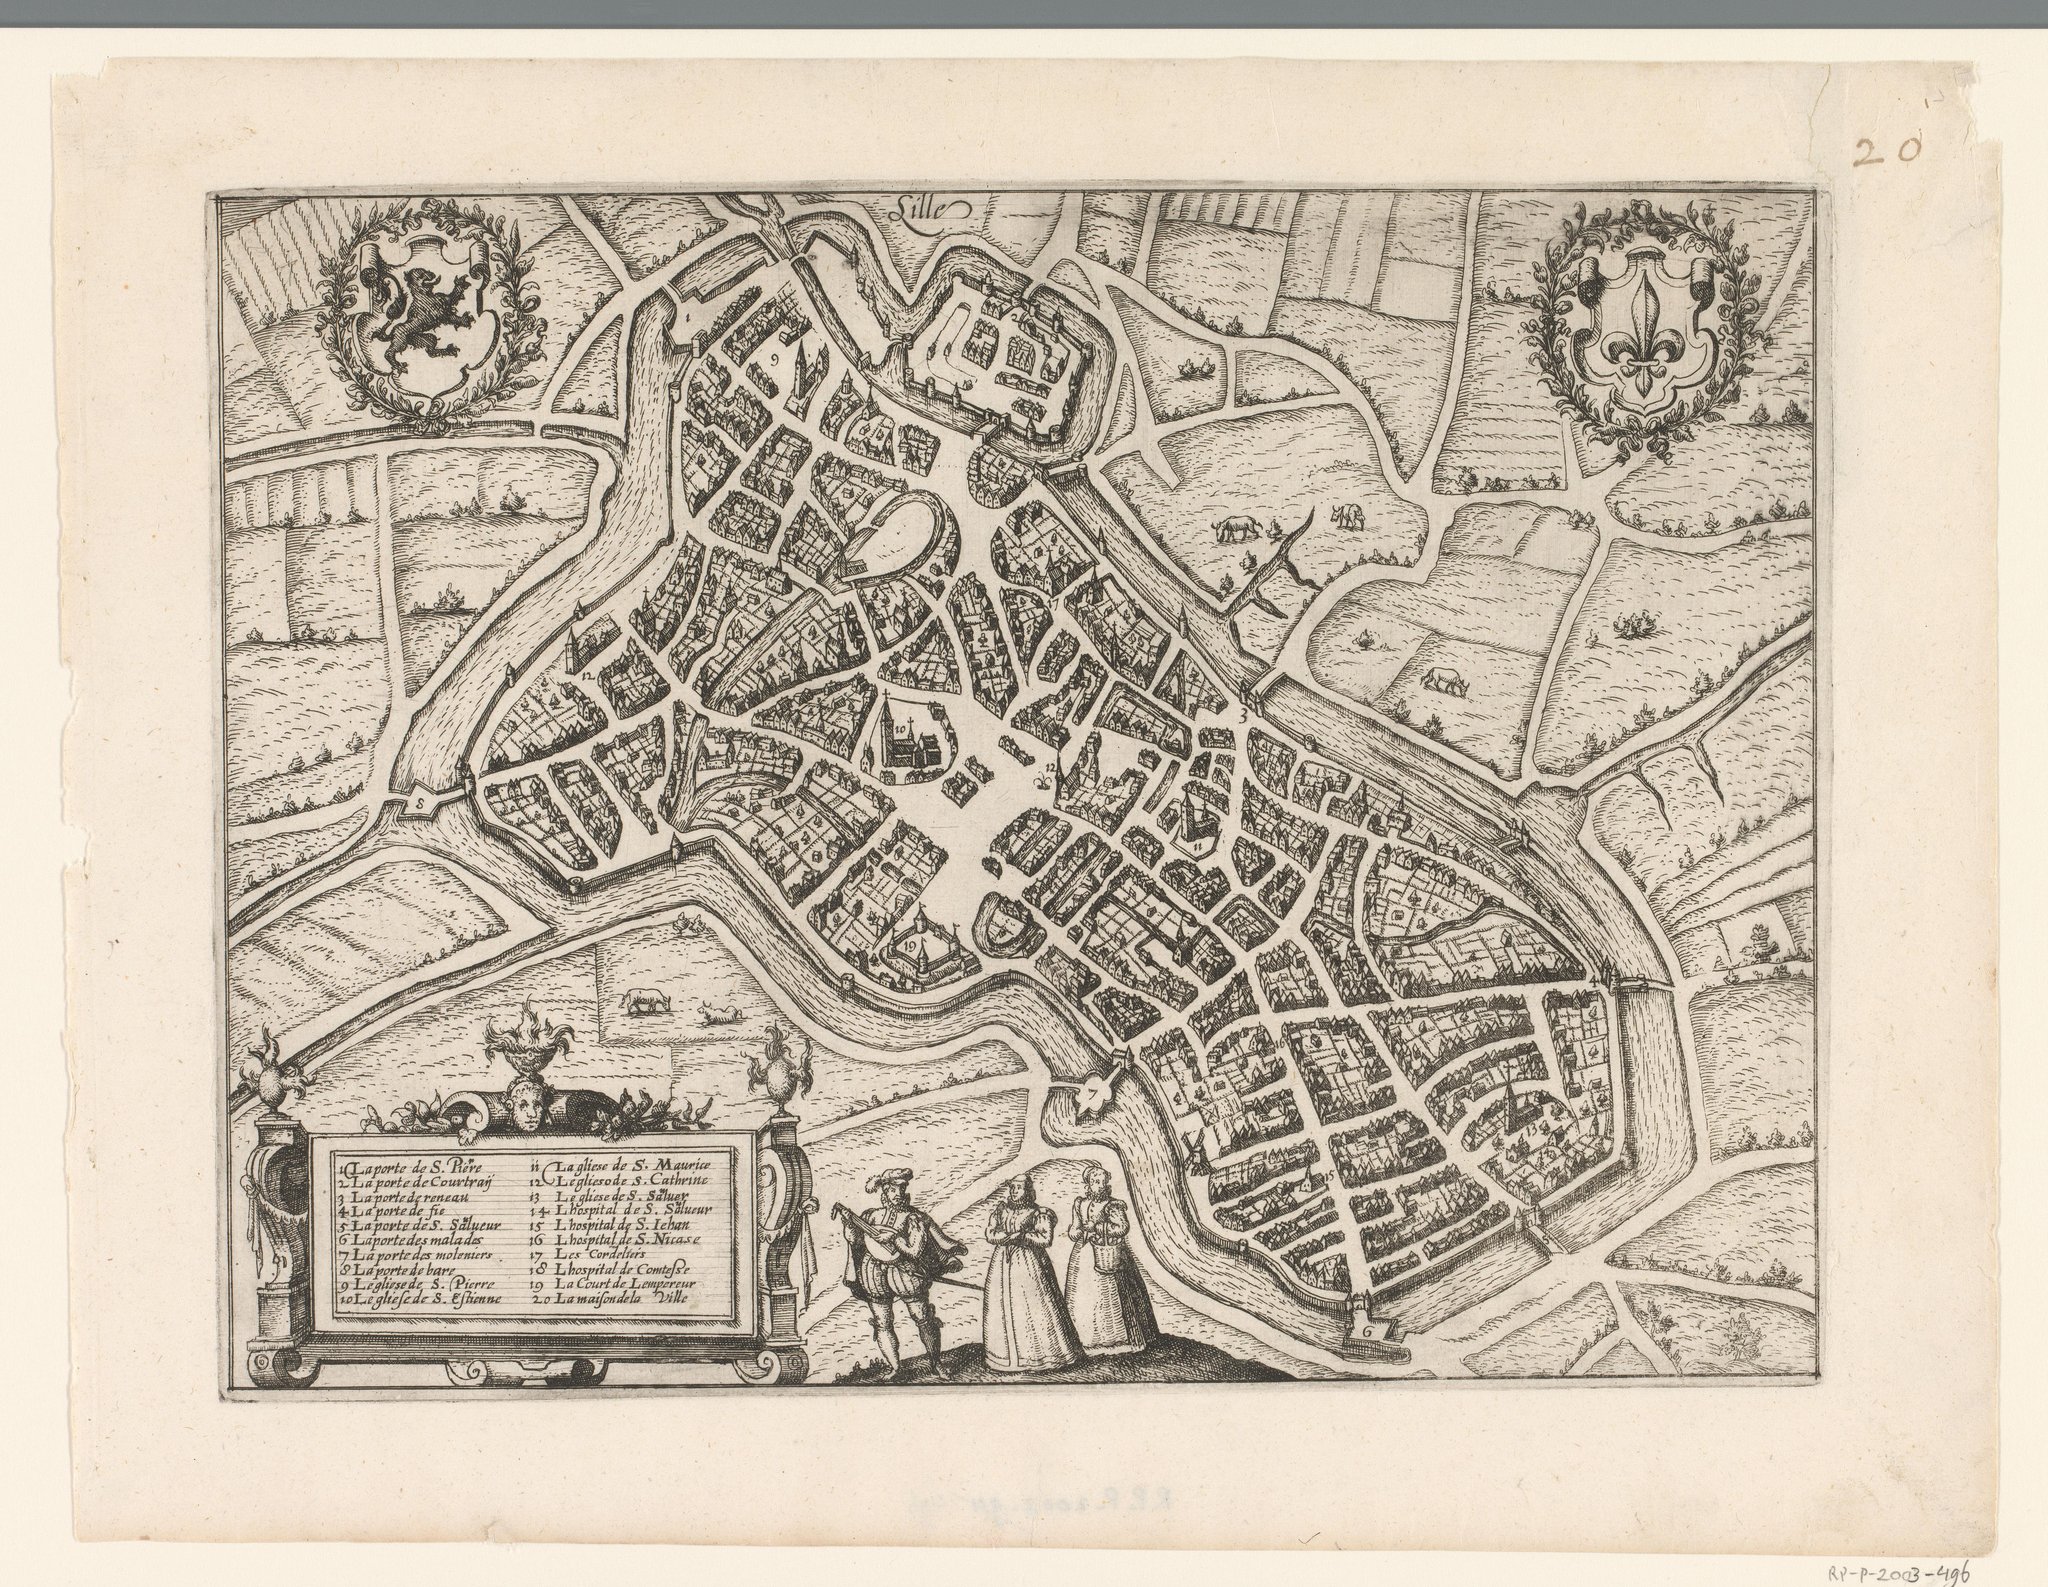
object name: area plan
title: Lille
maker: Anonymous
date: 1607-1609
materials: paper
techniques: etching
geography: northern netherlands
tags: one person playing string instrument (plucked), lute, and special forms of lute, e.g.: theorbo, maps of cities, lille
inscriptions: number: ‘20’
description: Plattegrond van de stad Lille (Rijsel). Midden boven de titel, linksboven het wapen van Vlaanderen, rechtsboven het stadswapen. Linksonder de legenda 1-20, daarnaast een man spelend op een luit en twee vrouwen. Onderdeel van de verzameling kaarten genomen uit een latere editie van: Descrittione di tutti i Paesi Bassi van Lodovico Guicciardini.